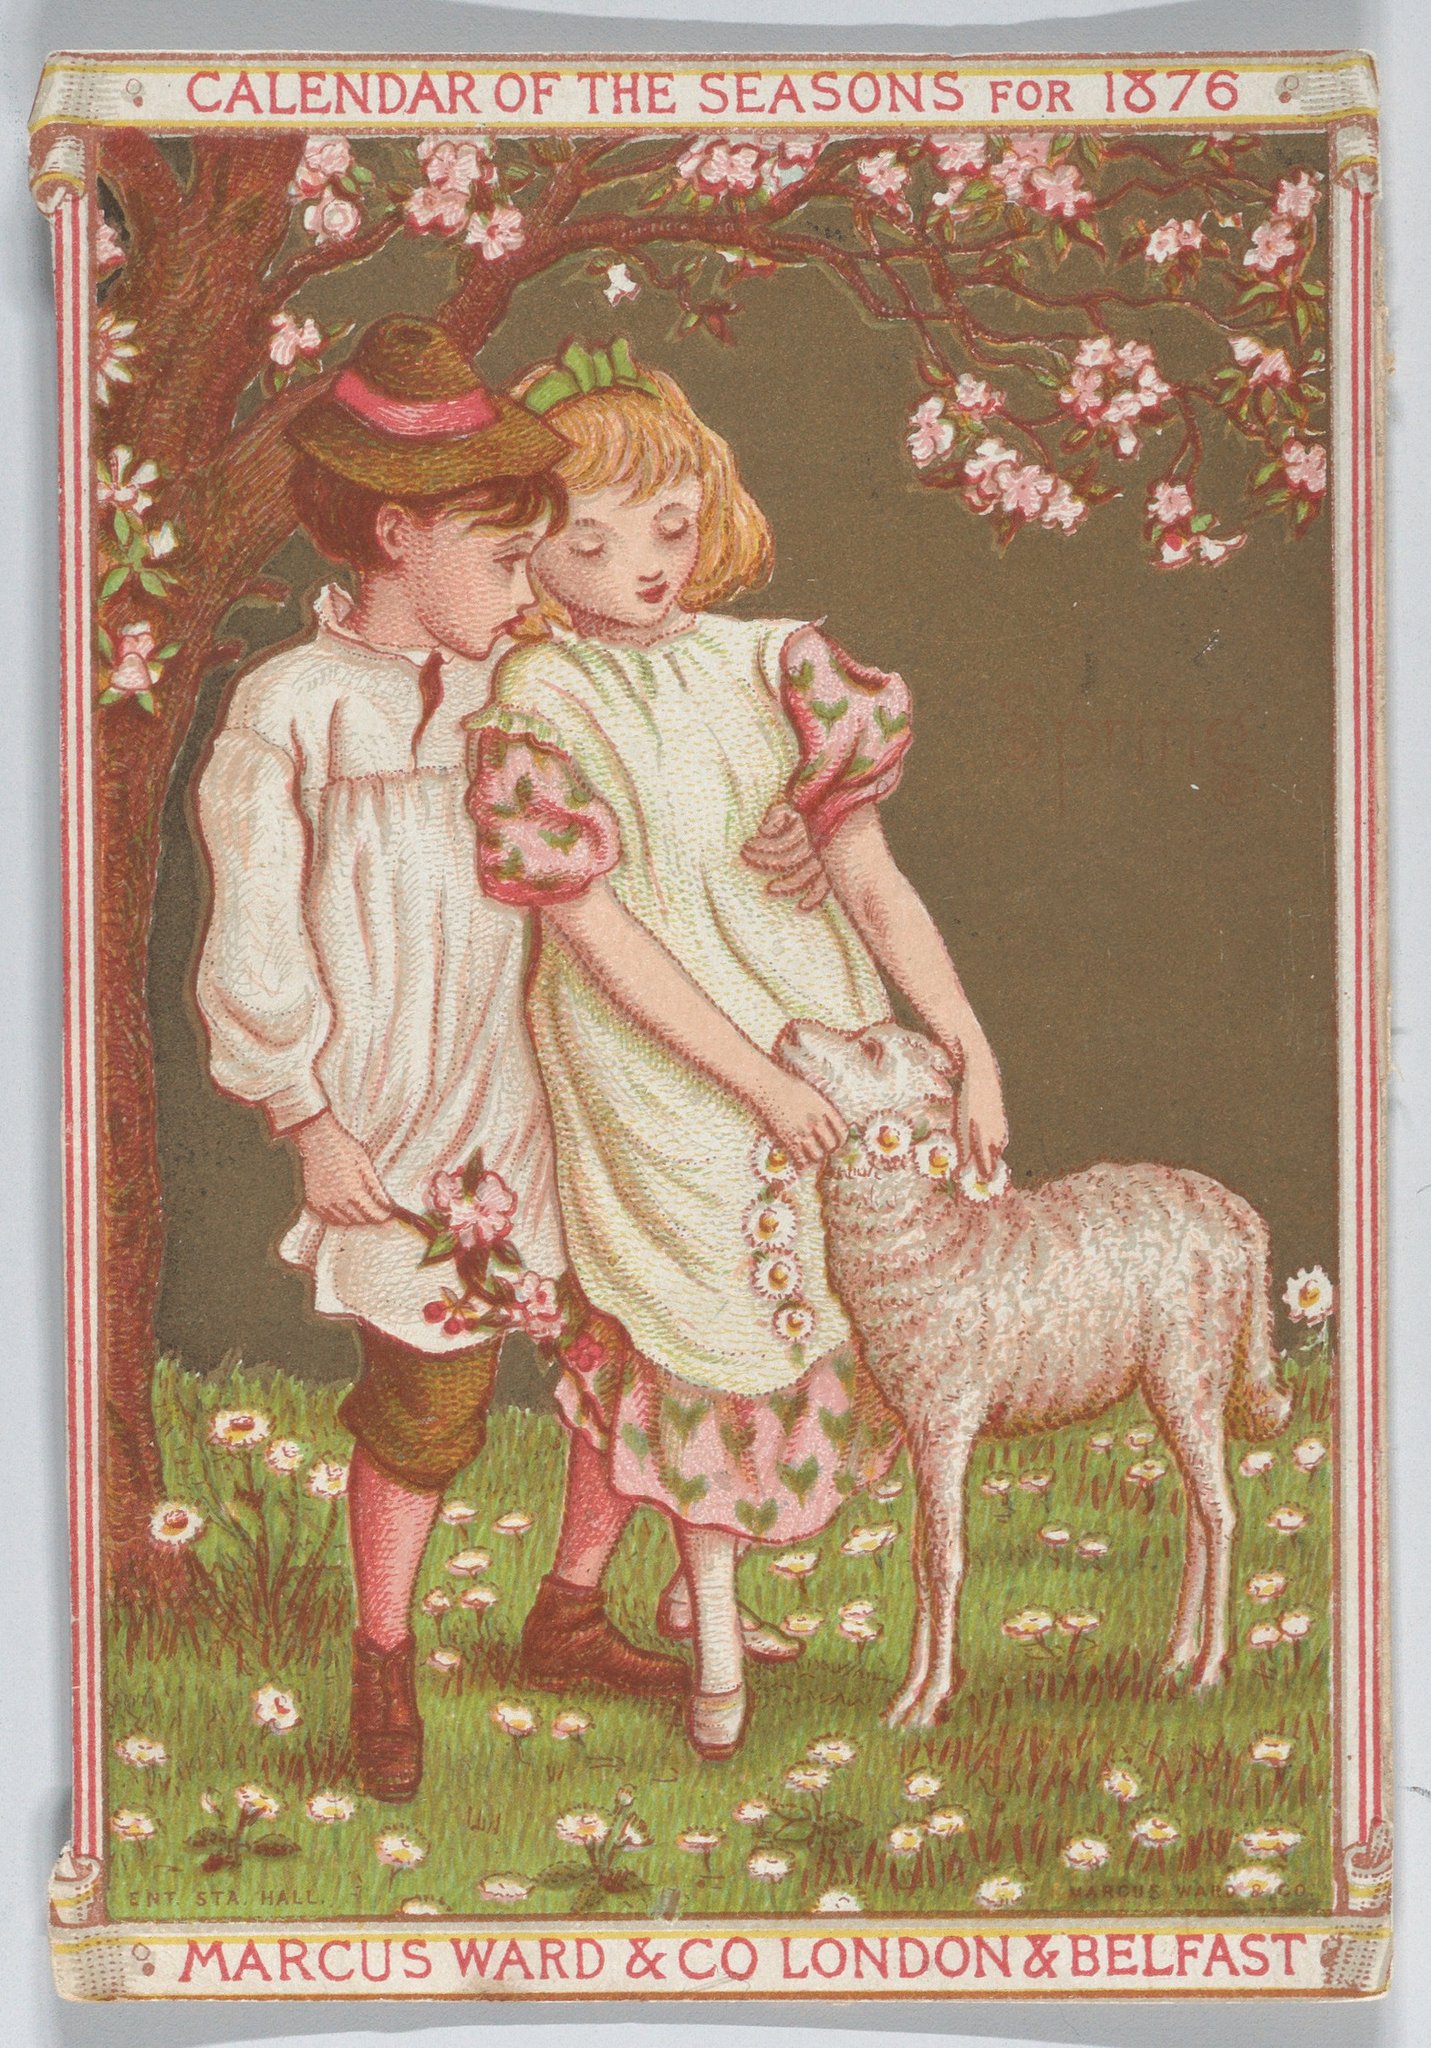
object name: valentine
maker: kate greenaway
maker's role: artist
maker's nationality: british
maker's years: 1846-1901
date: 1876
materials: gold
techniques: chromolithography, lithograph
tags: boys,girls,lambs